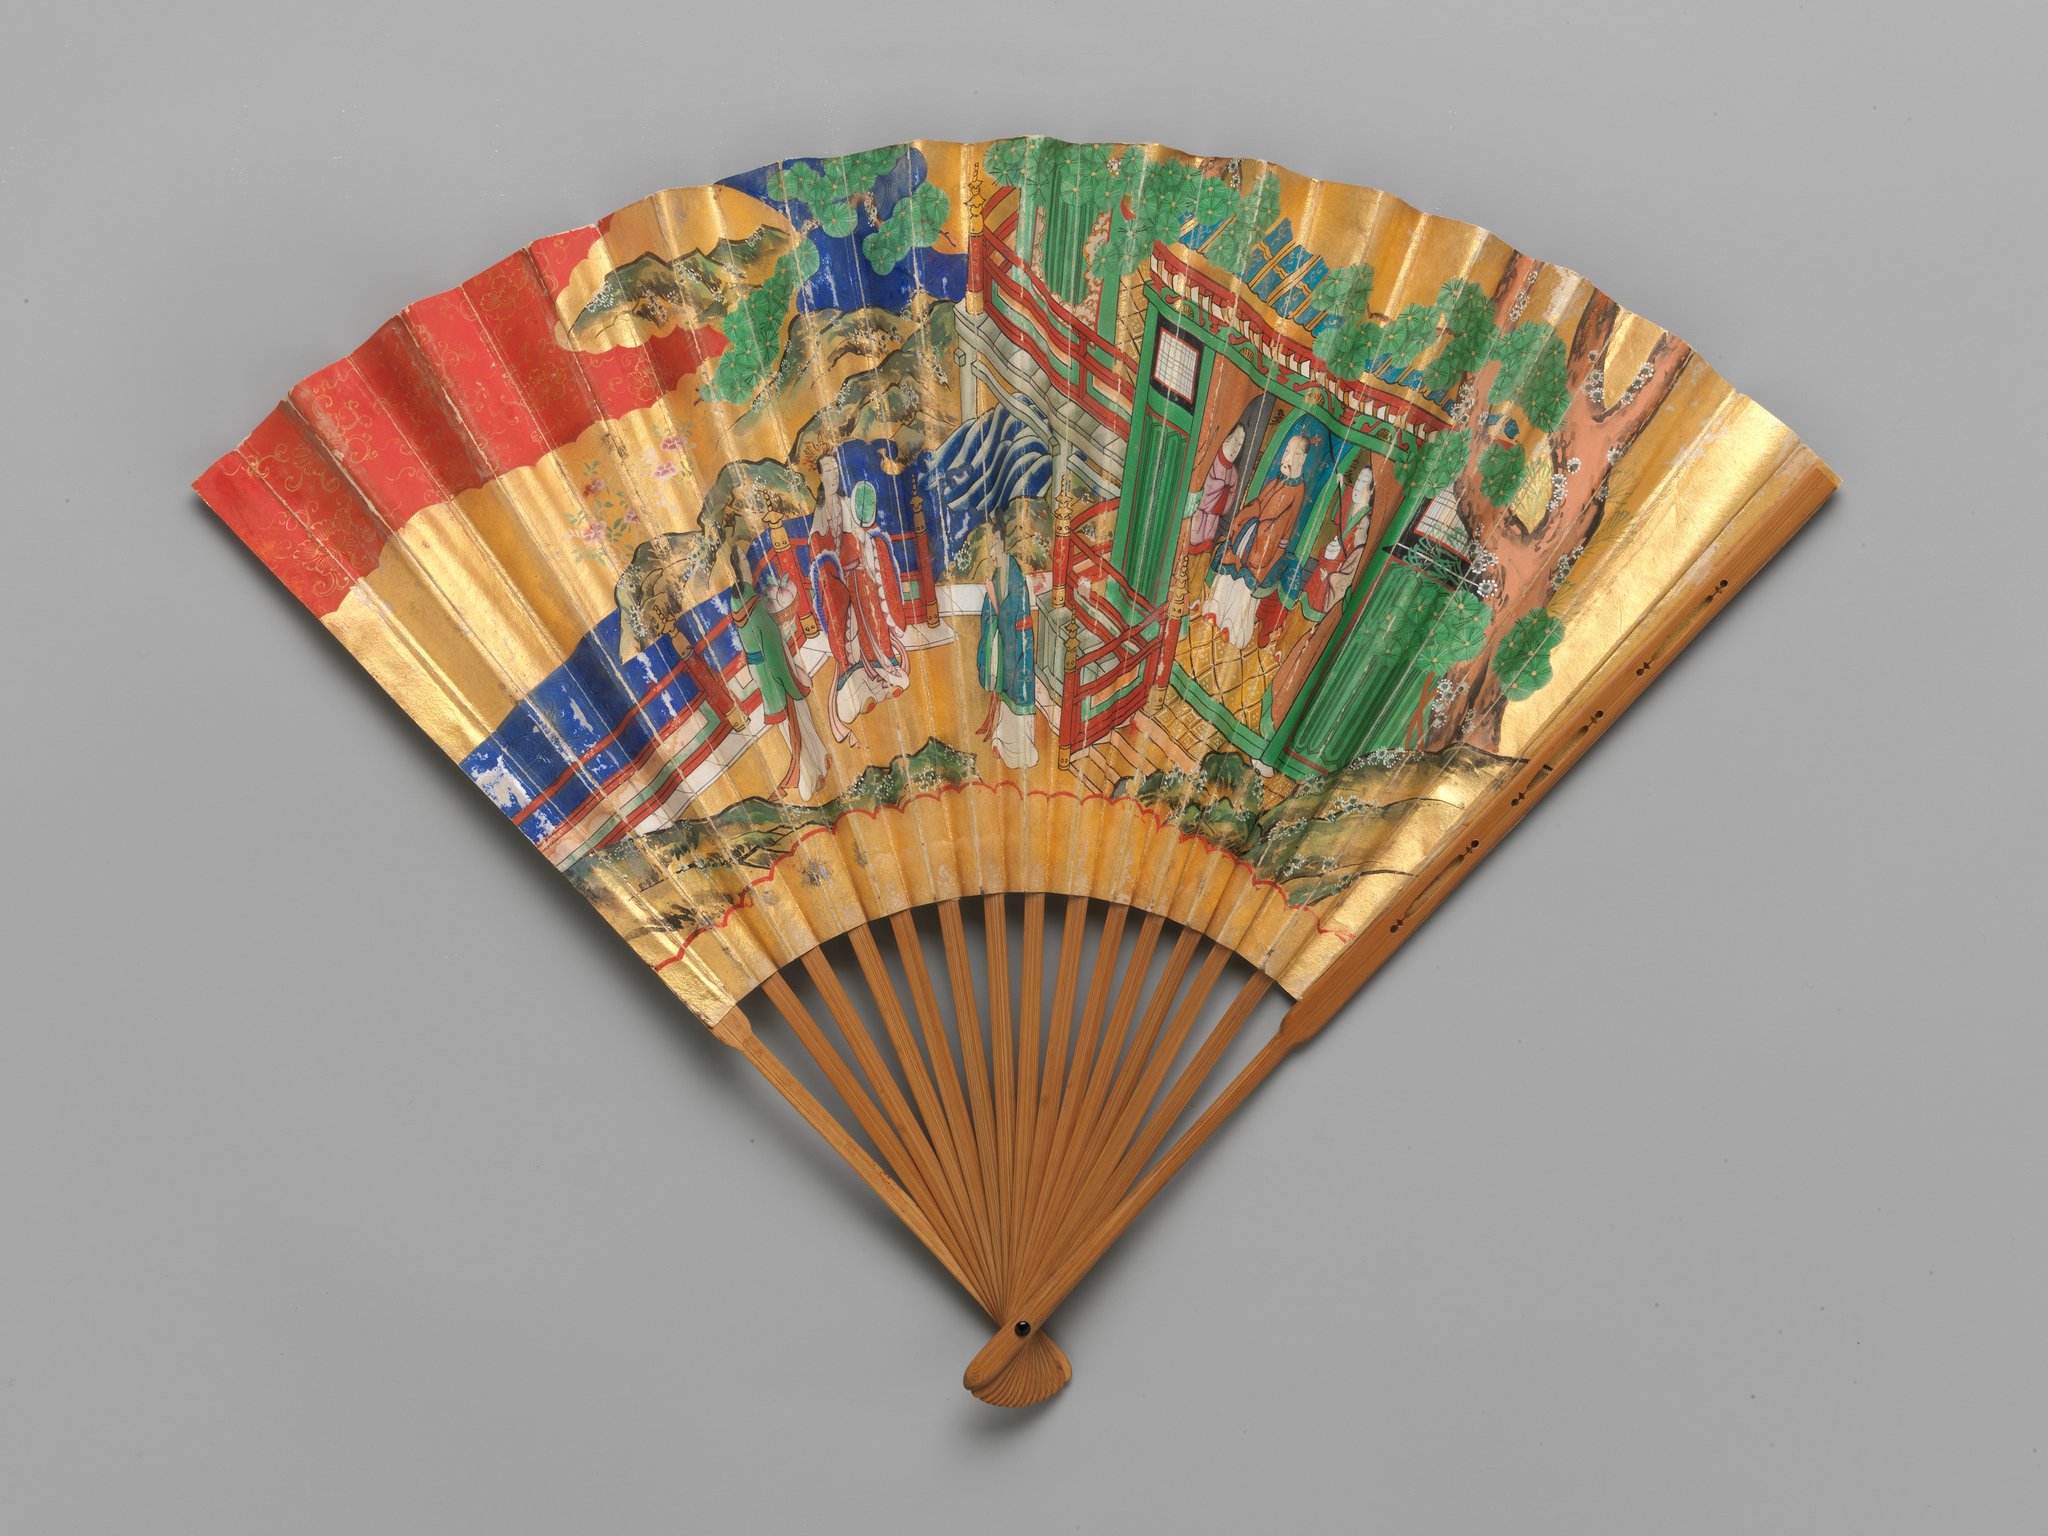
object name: folding fan chūkei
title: Chūkei Fan with Queen Mother of the West and King Mu of Zhou (obverse) and Plum Tree and Young Pines (reverse)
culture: japanese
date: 1801-1900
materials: bamboo, gold leaf, gold paint, ink, lacquer, paper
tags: balconies,houses,men,women